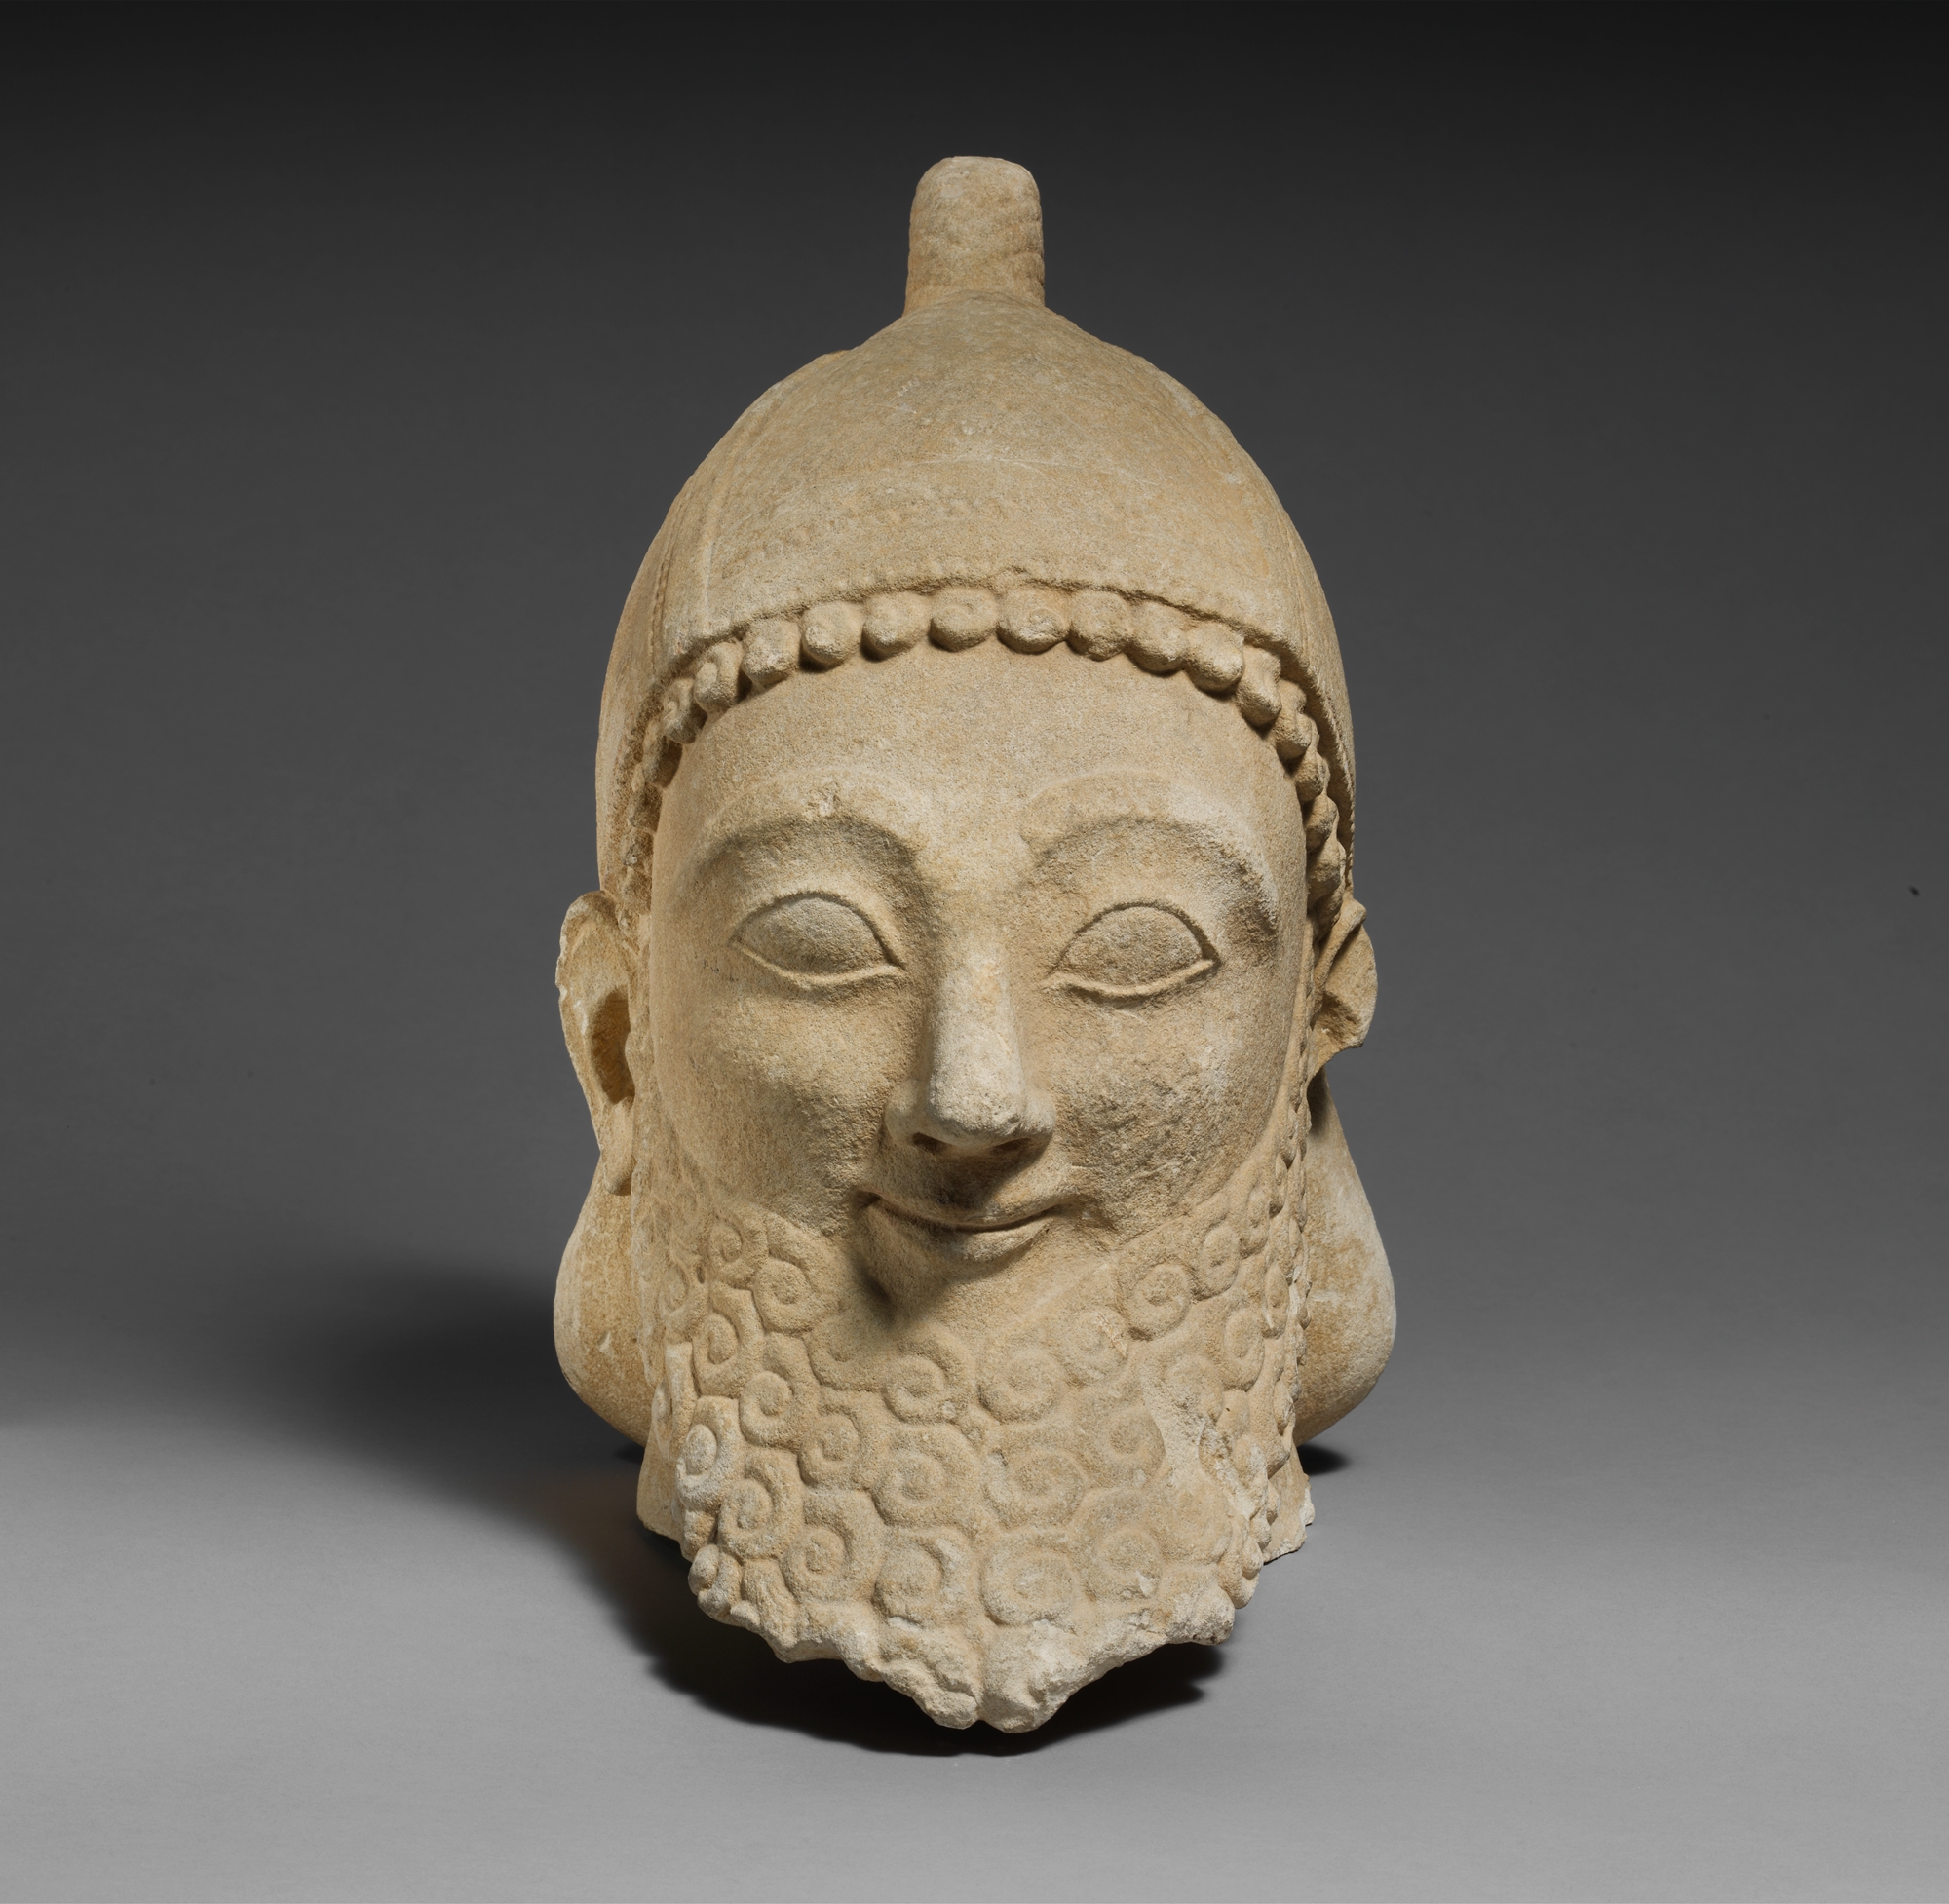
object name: head of a man in assyrian helmet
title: Limestone head of a bearded male wearing a conical helmet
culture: cypriot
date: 600-401 BCE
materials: limestone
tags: helmets,heads,men